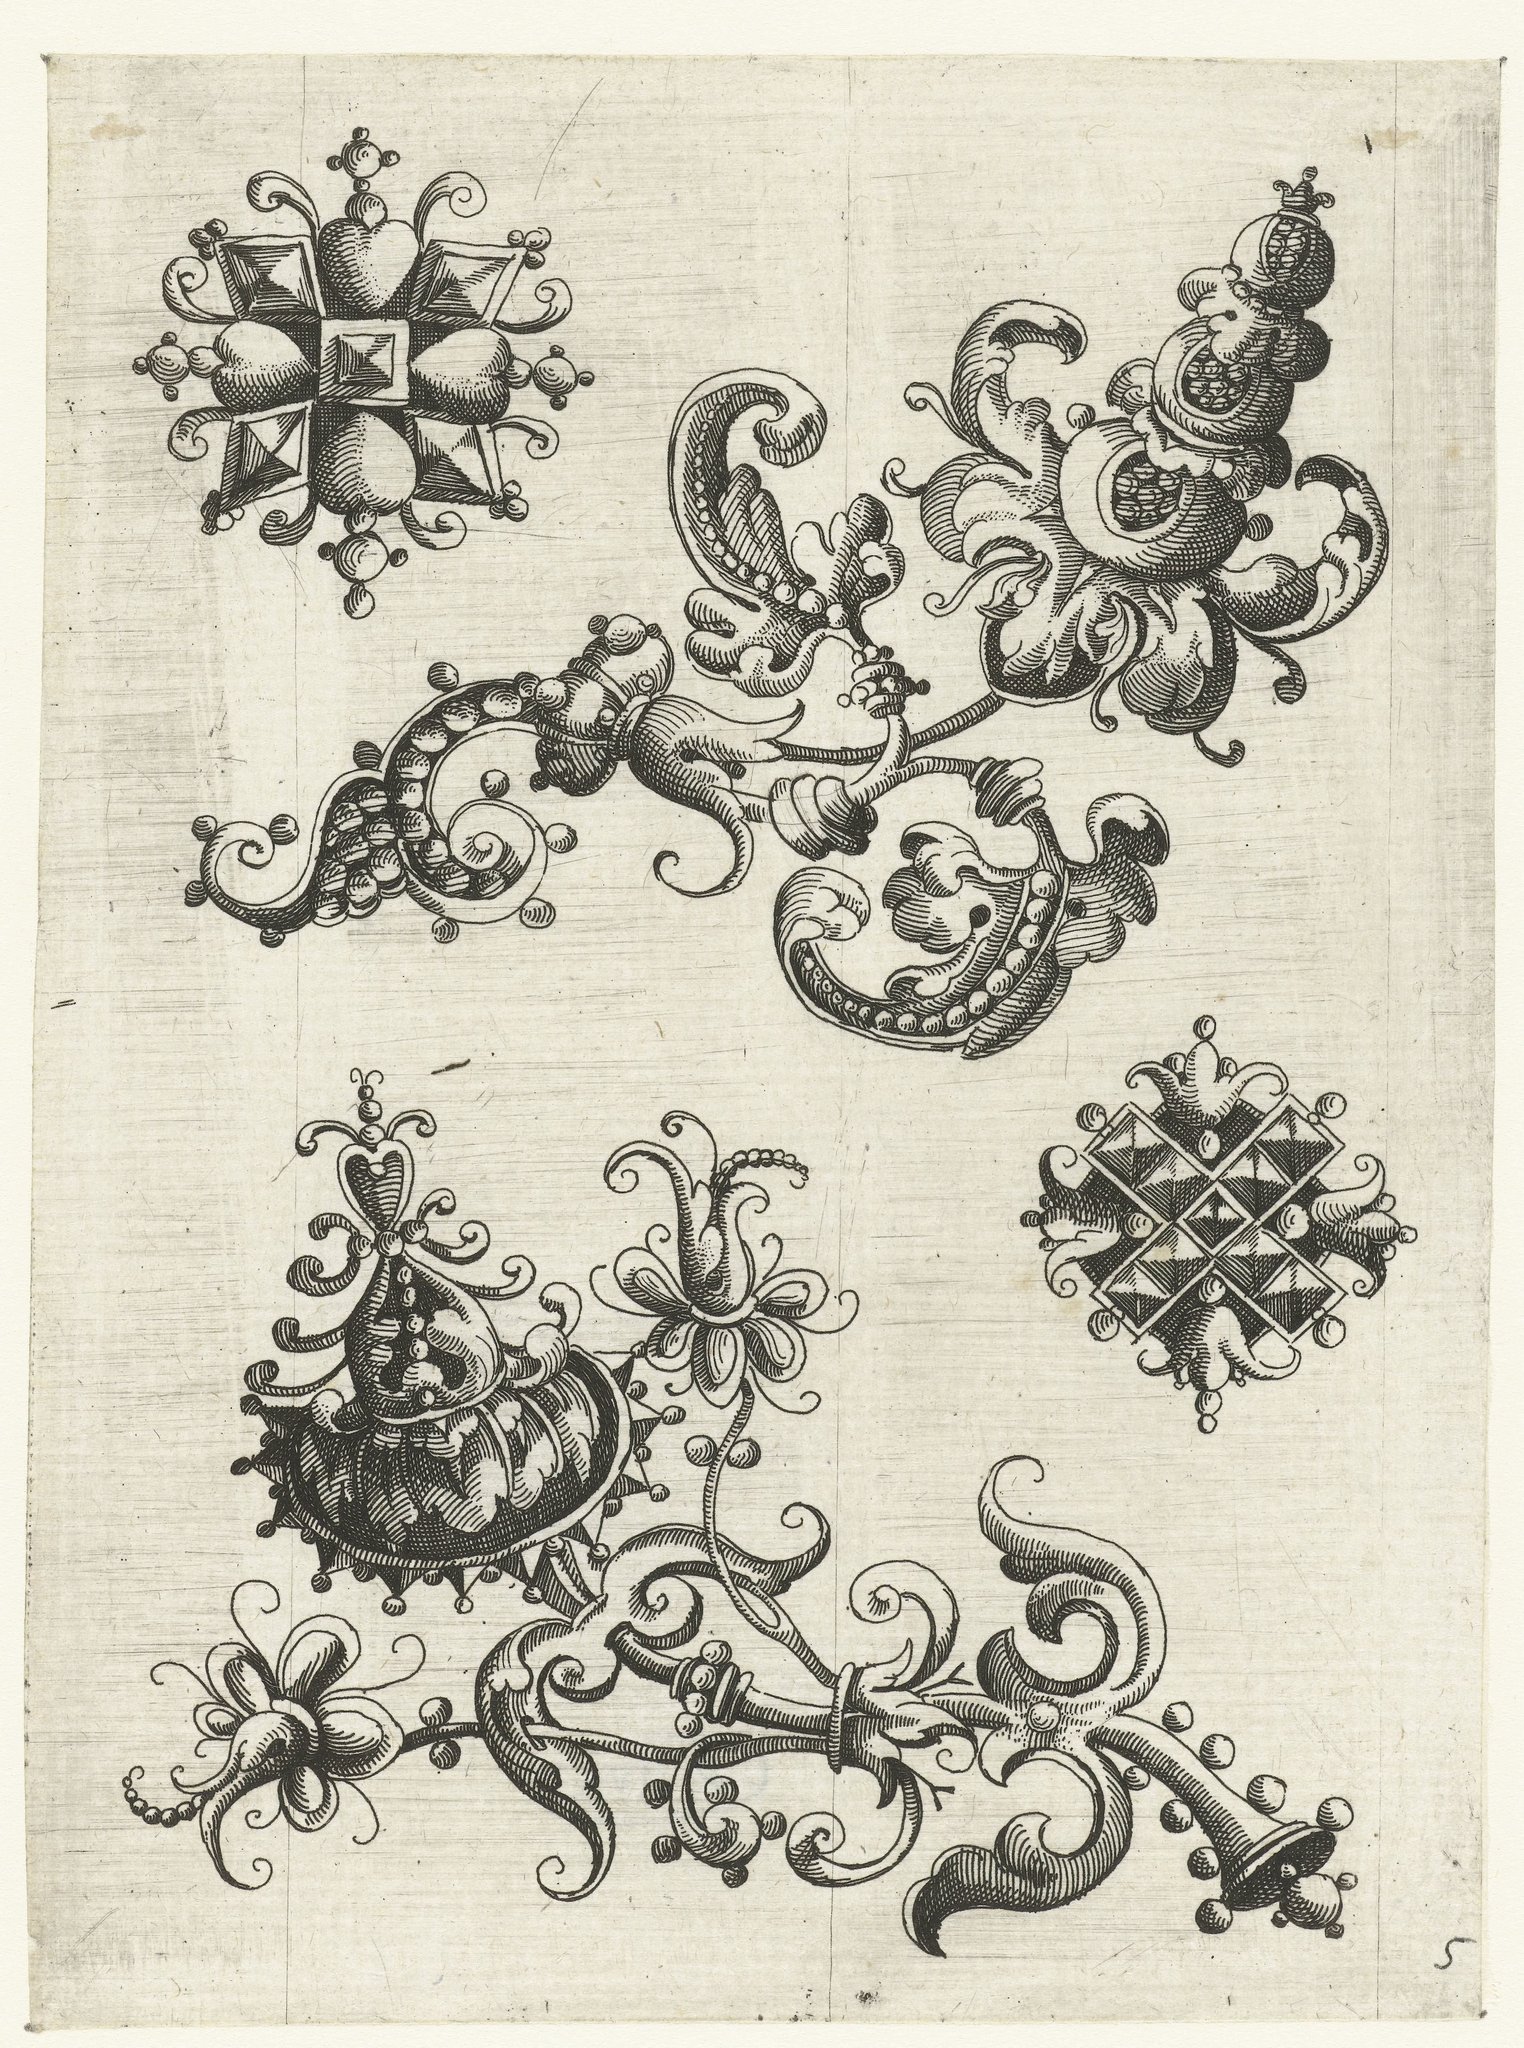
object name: print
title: Voorbeelden voor borduurwerk in goud met edelstenen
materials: paper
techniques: etching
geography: germany